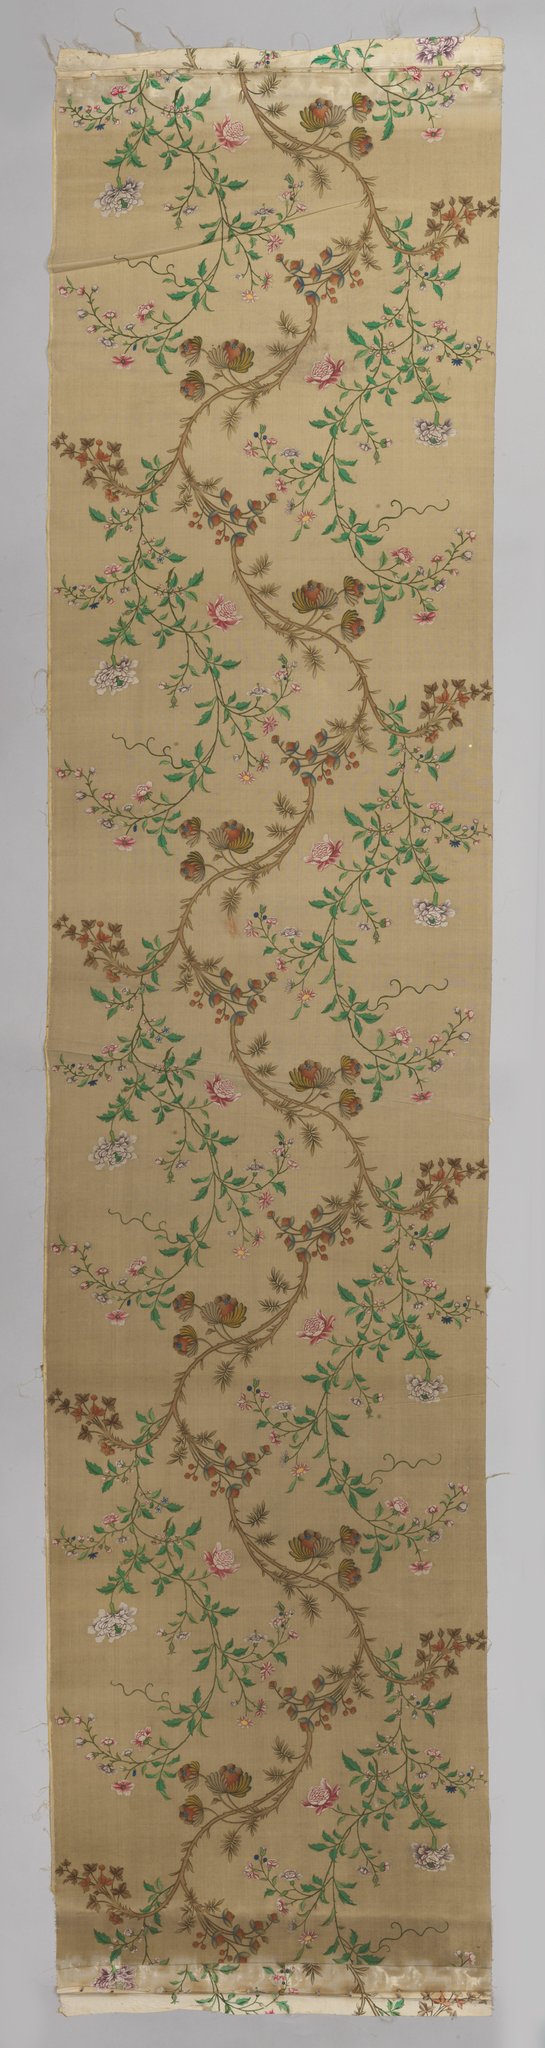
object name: upholstery fabric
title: Bespanningsstof met decor van takken, bladeren, bloemen en vruchten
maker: Anonymous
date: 1750-1790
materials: paint, silk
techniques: printing, weave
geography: china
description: Een baan veelkleurig beschilderde creme bespanningsstof van zijde. Zie beschrijving bij A.